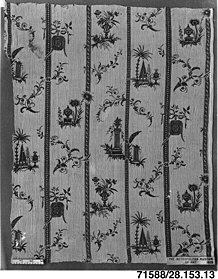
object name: fragment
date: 1767-1800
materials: cotton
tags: flowers,leaves,trees